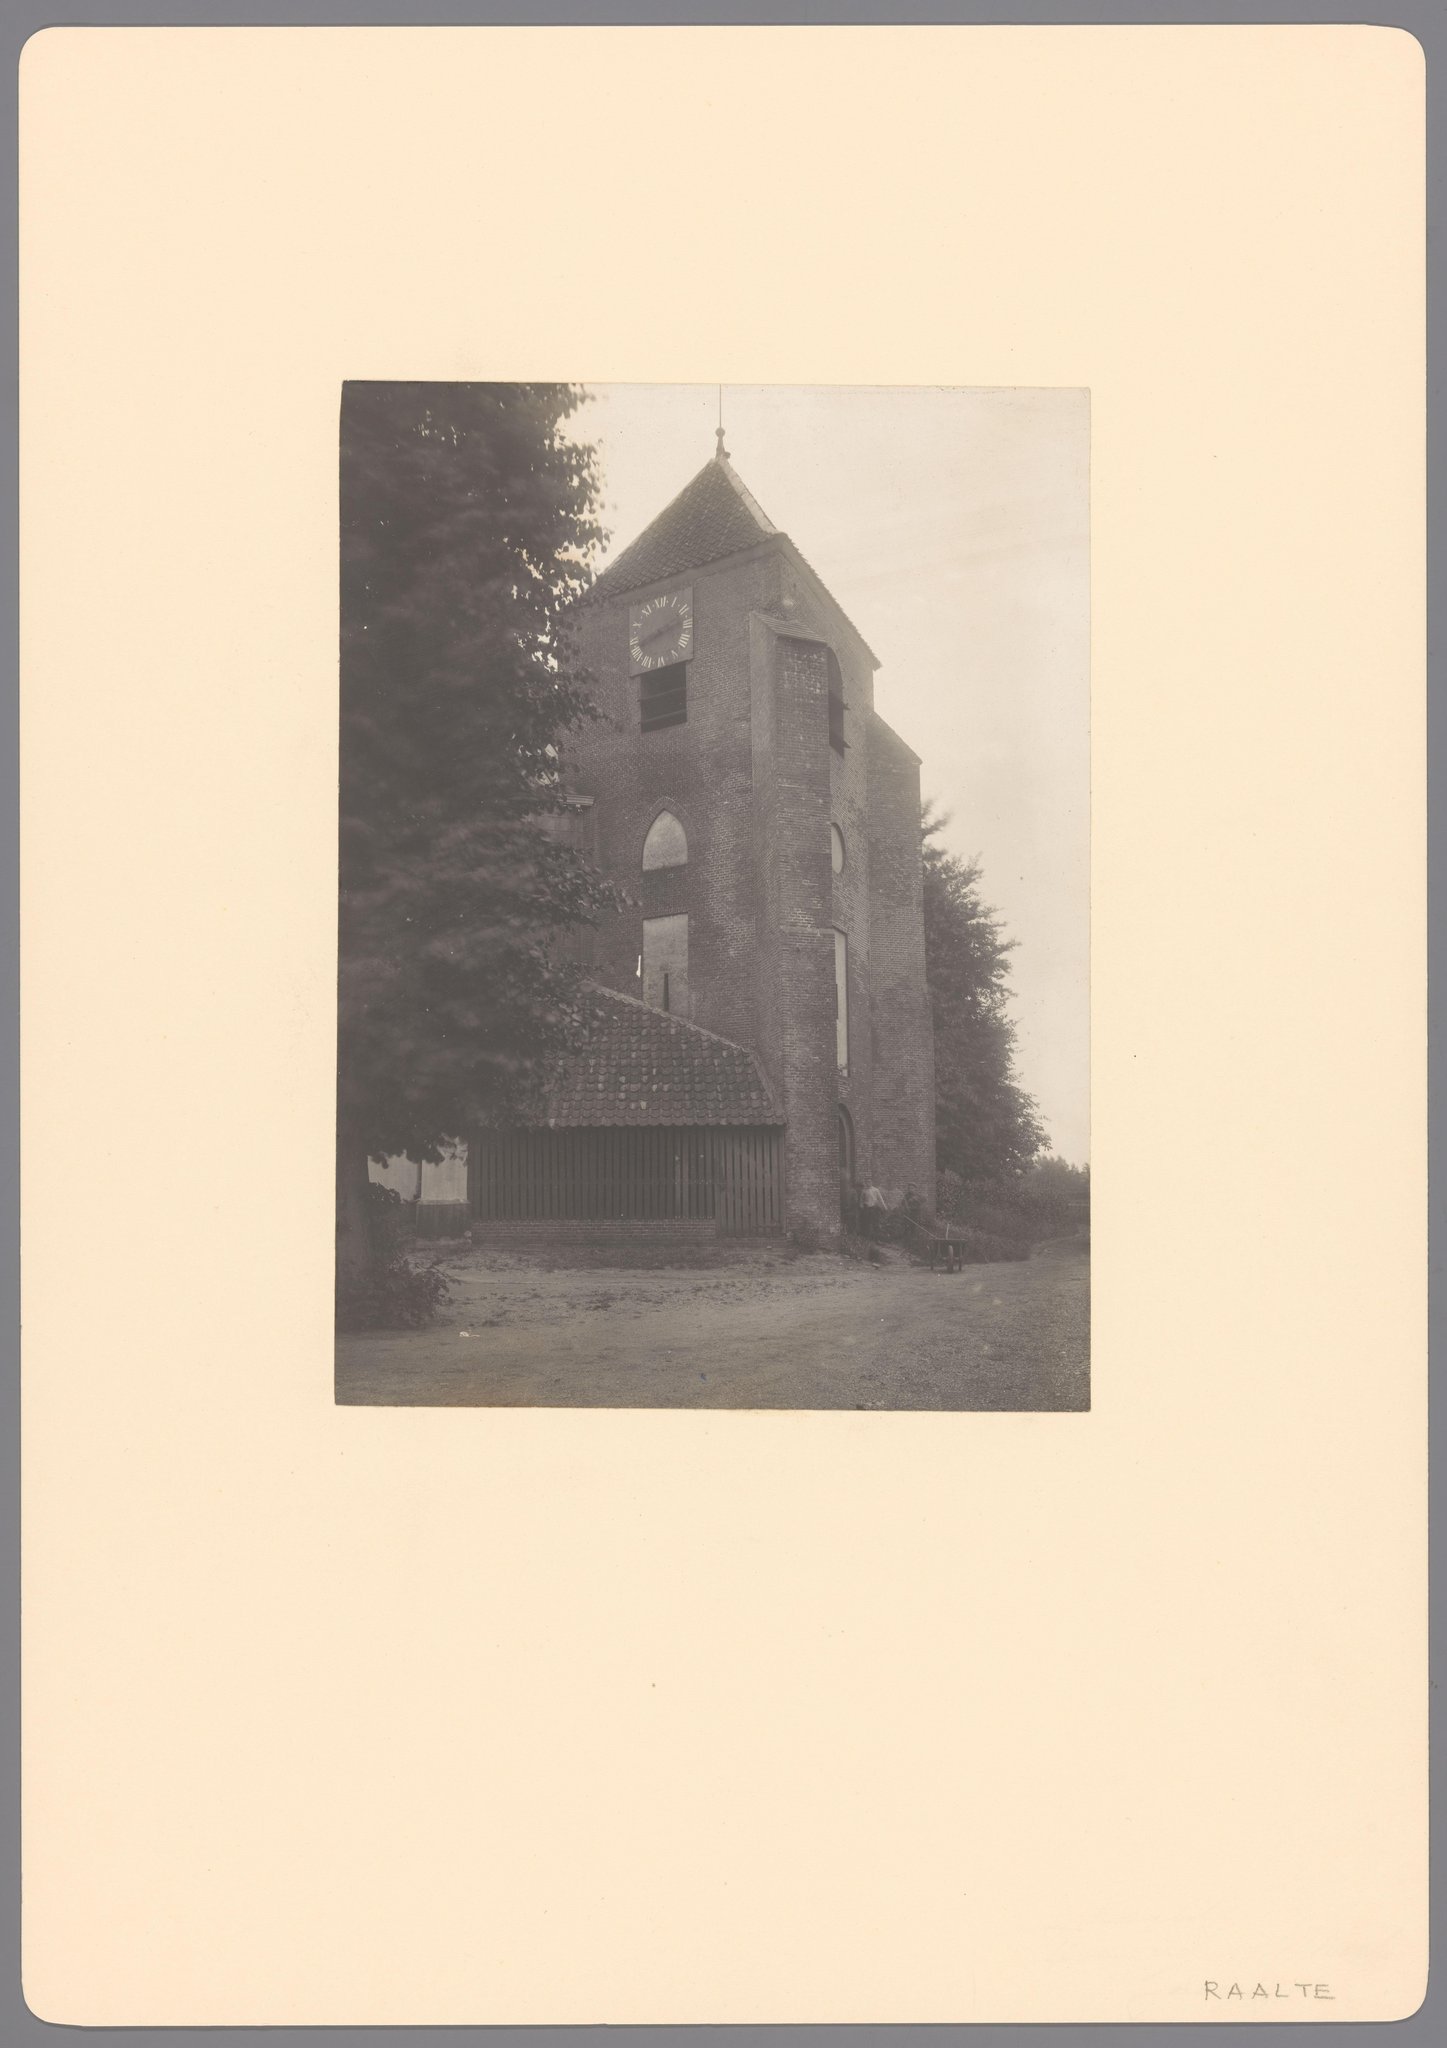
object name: photograph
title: Toren van de Plaskerk te Raalte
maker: anoniem (monumentenzorg)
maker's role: fotograaf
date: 1910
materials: cardboard, photographic support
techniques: gelatin silver print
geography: raalte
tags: parts of church exterior and annexes: tower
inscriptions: annotation: ‘Raalte/ Toren v.d. Ned. Herv. Kerk/ Juli 1910’, annotation: ‘Raalte’